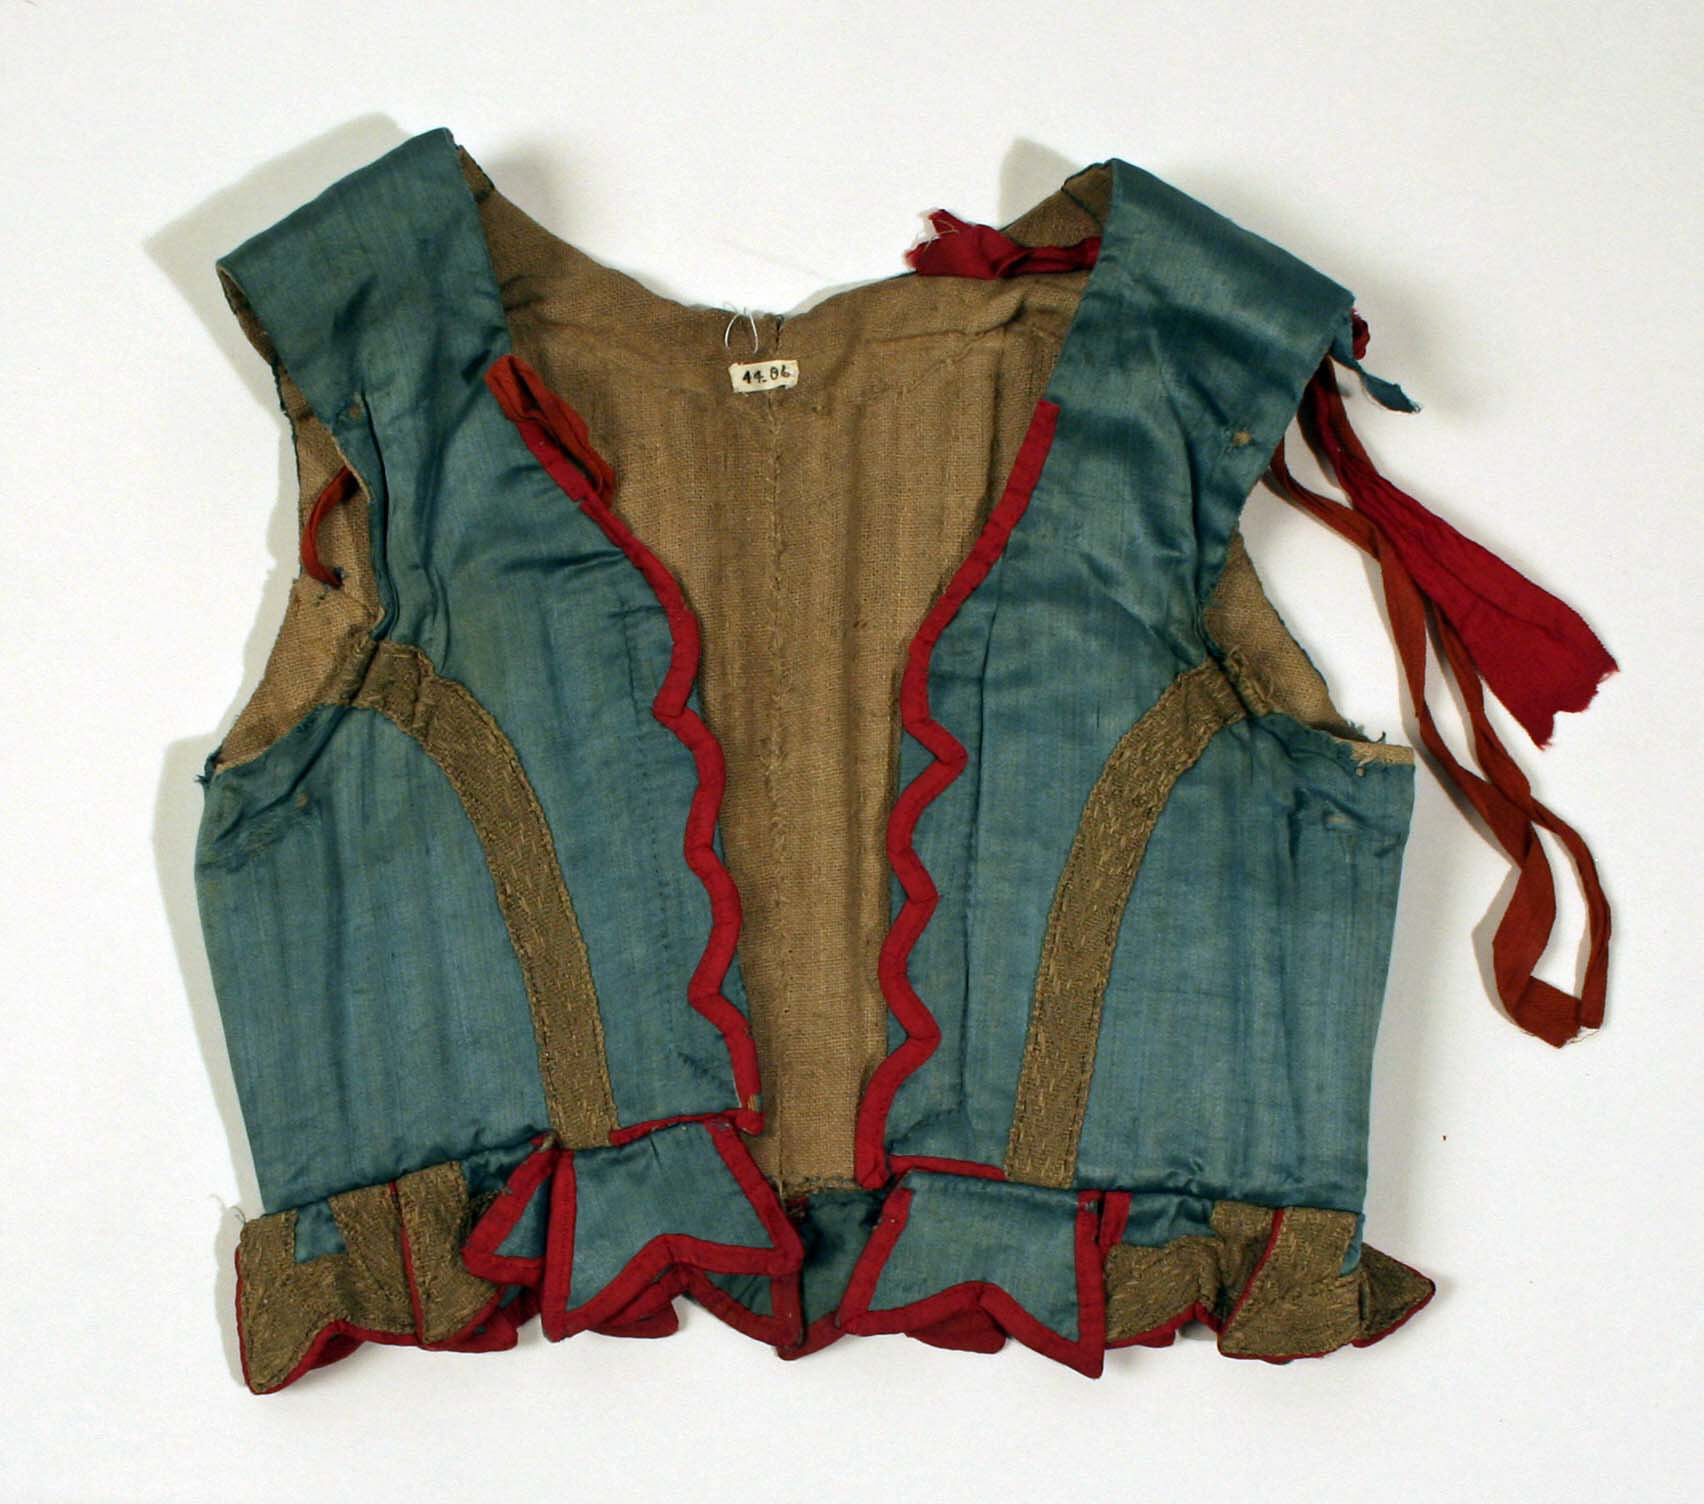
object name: stay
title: Bodice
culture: american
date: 1700-1799